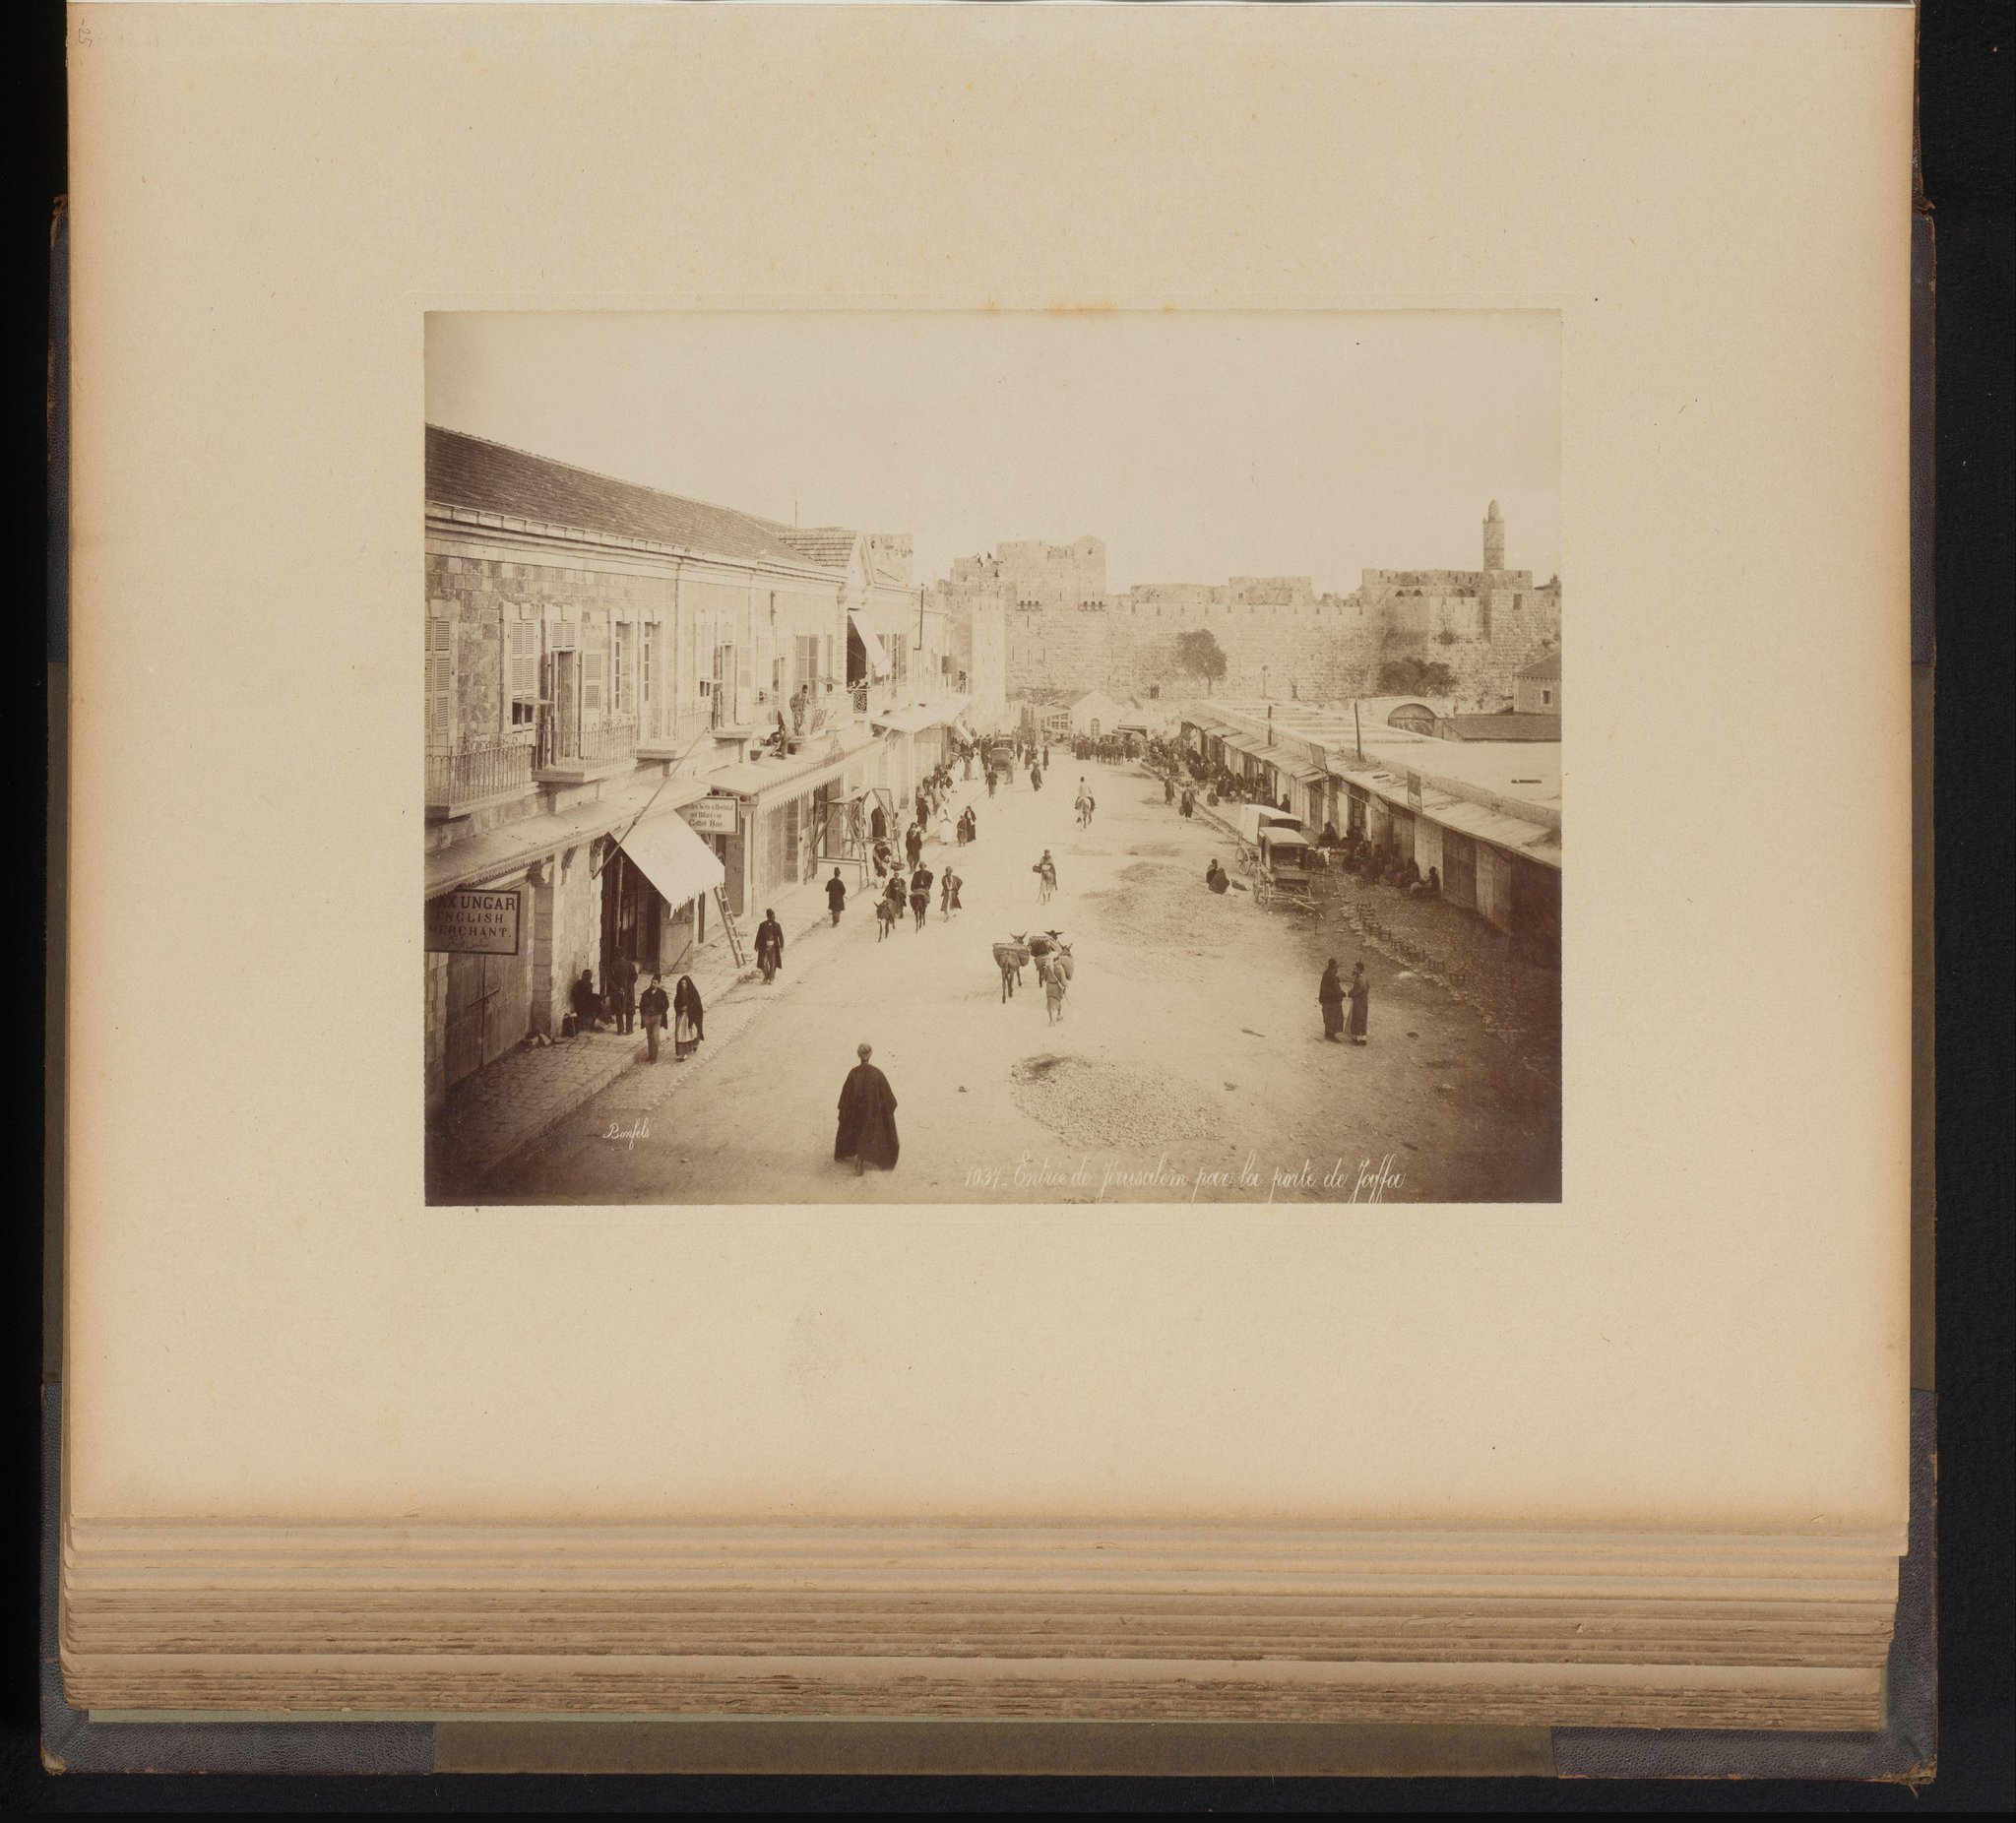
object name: album leaf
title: Straat in Jeruzalem vanuit de Jaffapoort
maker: félix bonfils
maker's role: fotograaf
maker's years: 1831-1885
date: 1867-1885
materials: paper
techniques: albumen print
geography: jerusalem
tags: street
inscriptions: number: ‘1037’